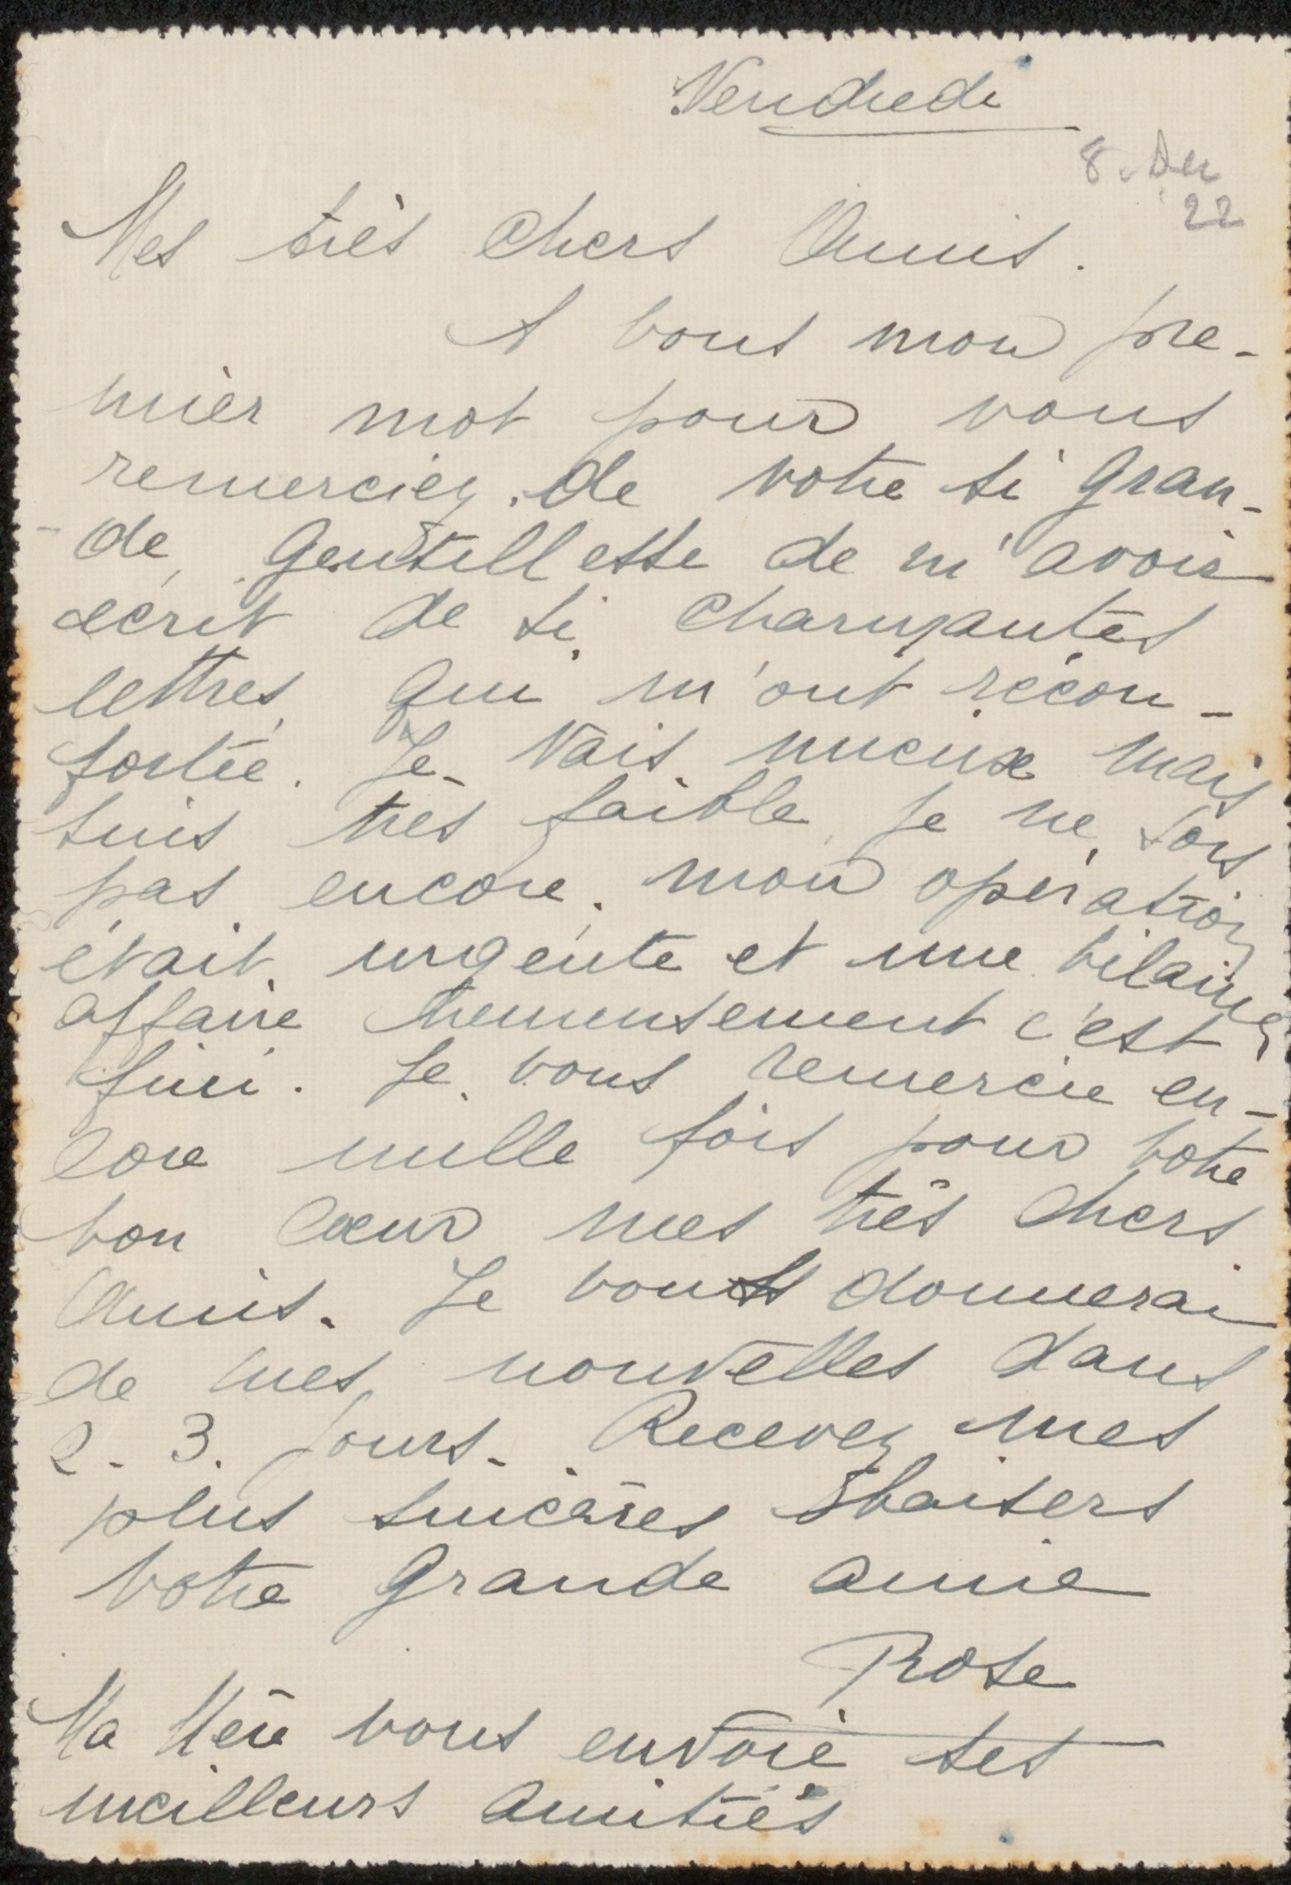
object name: letter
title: Brief aan Philip Zilcken en Henriette Wilhelmina van Baak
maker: rose imel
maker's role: draughtsman, painter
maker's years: 1901-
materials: ink, paper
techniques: pen, writing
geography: paris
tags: henriette wilhelmina van baak, the hague, painter, draughtsman, philip zilcken, diseases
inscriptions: collector's mark: ‘RPK’